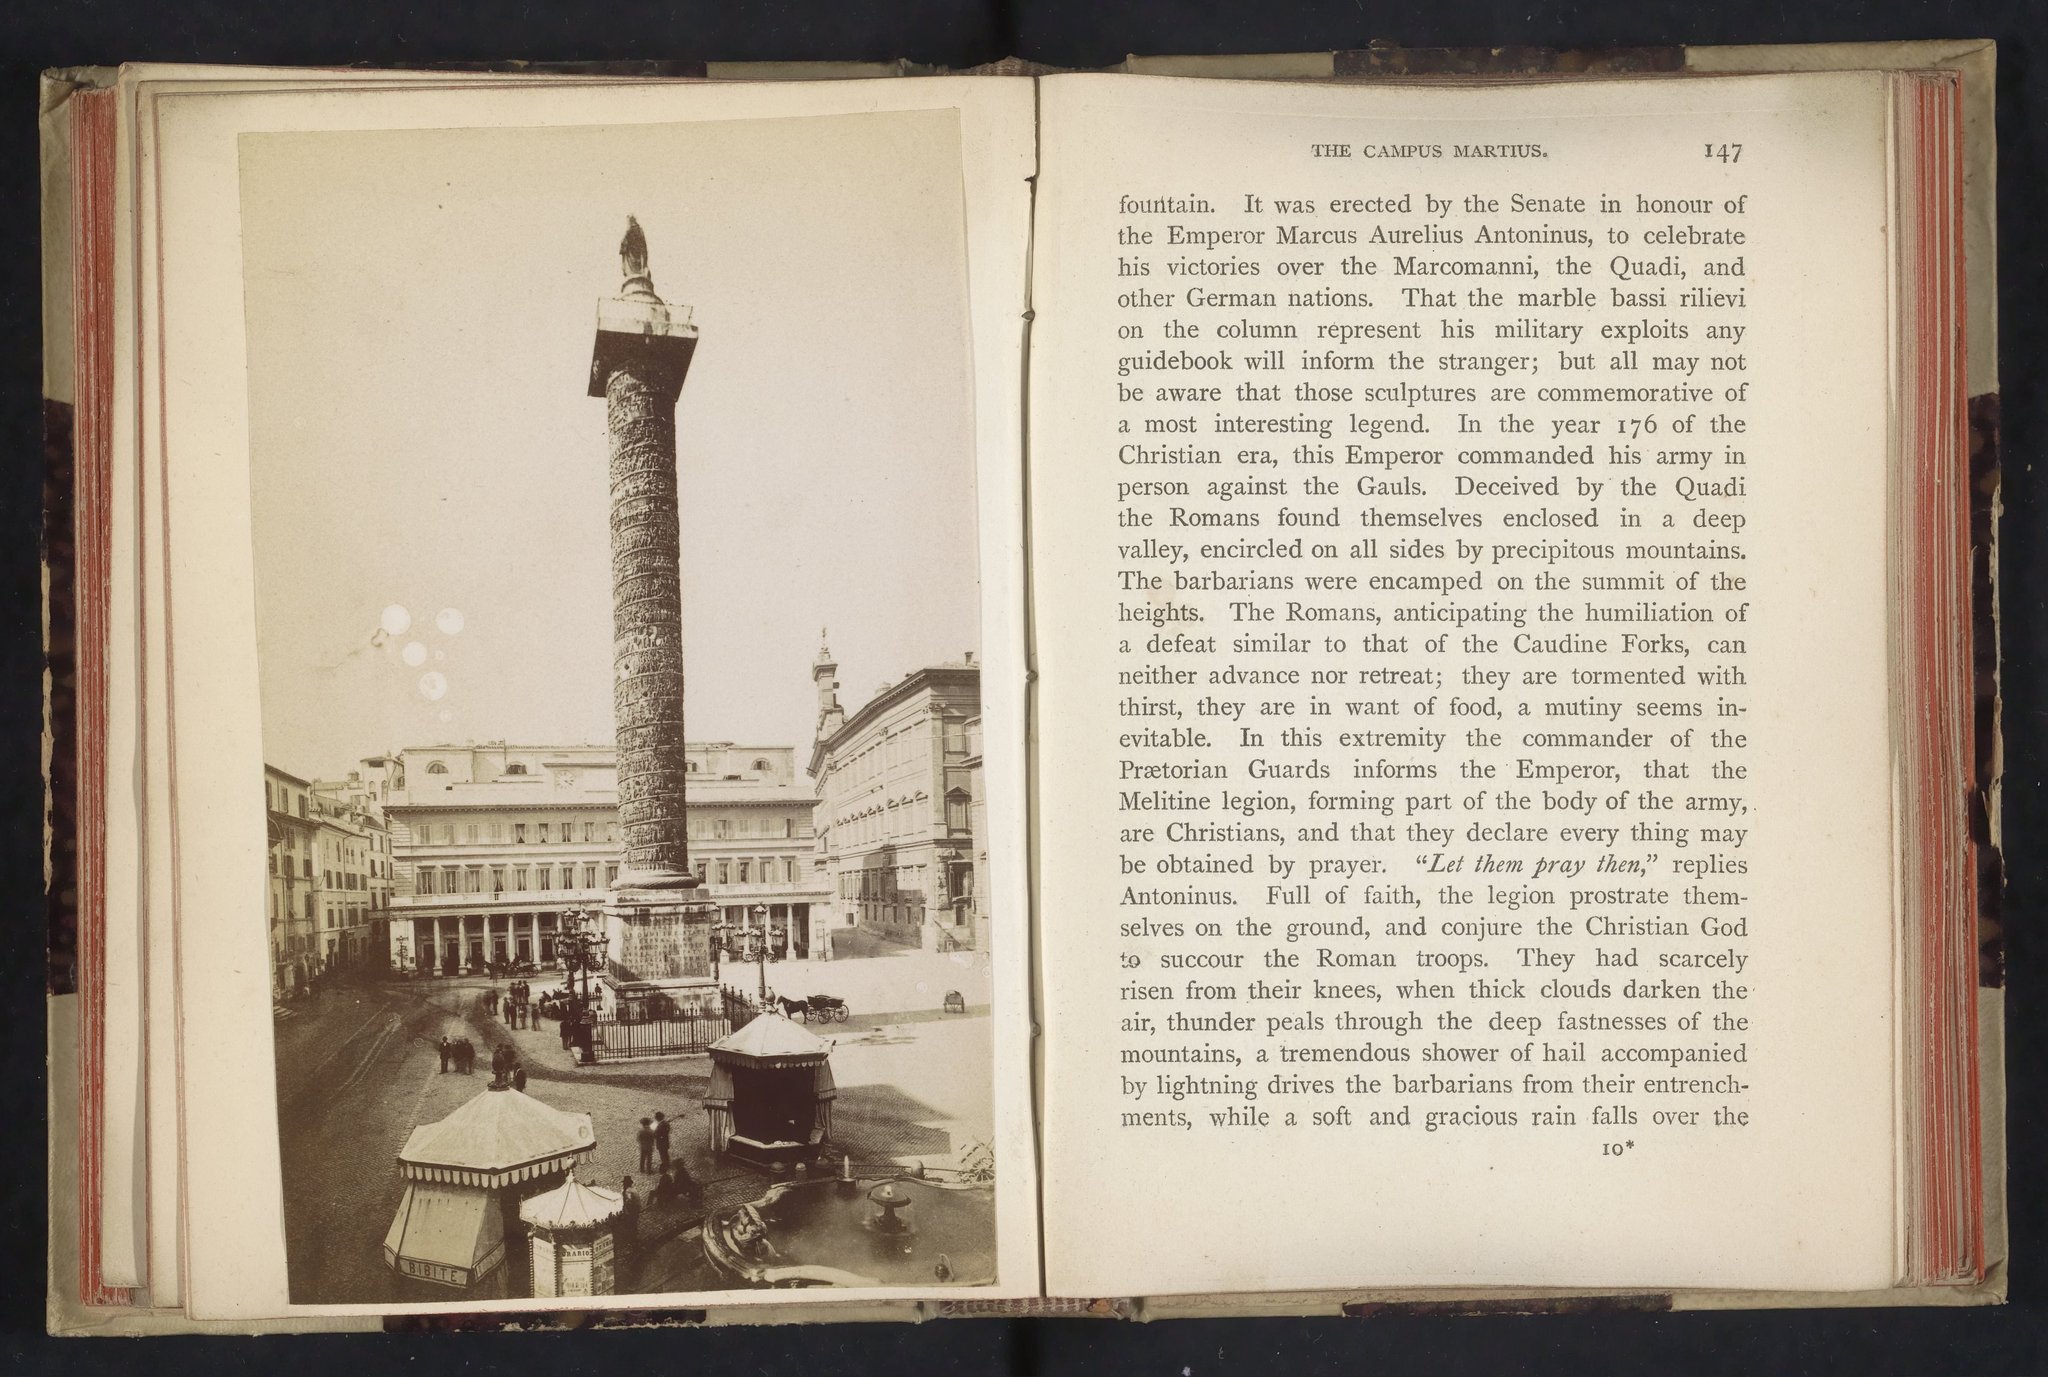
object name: photograph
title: Zuil van Marcus Aurelius op het Marsveld te Rome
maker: Anonymous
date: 1872-1882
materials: photographic support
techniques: albumen print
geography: marsveld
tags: square, place, circus, etc., triumphal column with helical friezes